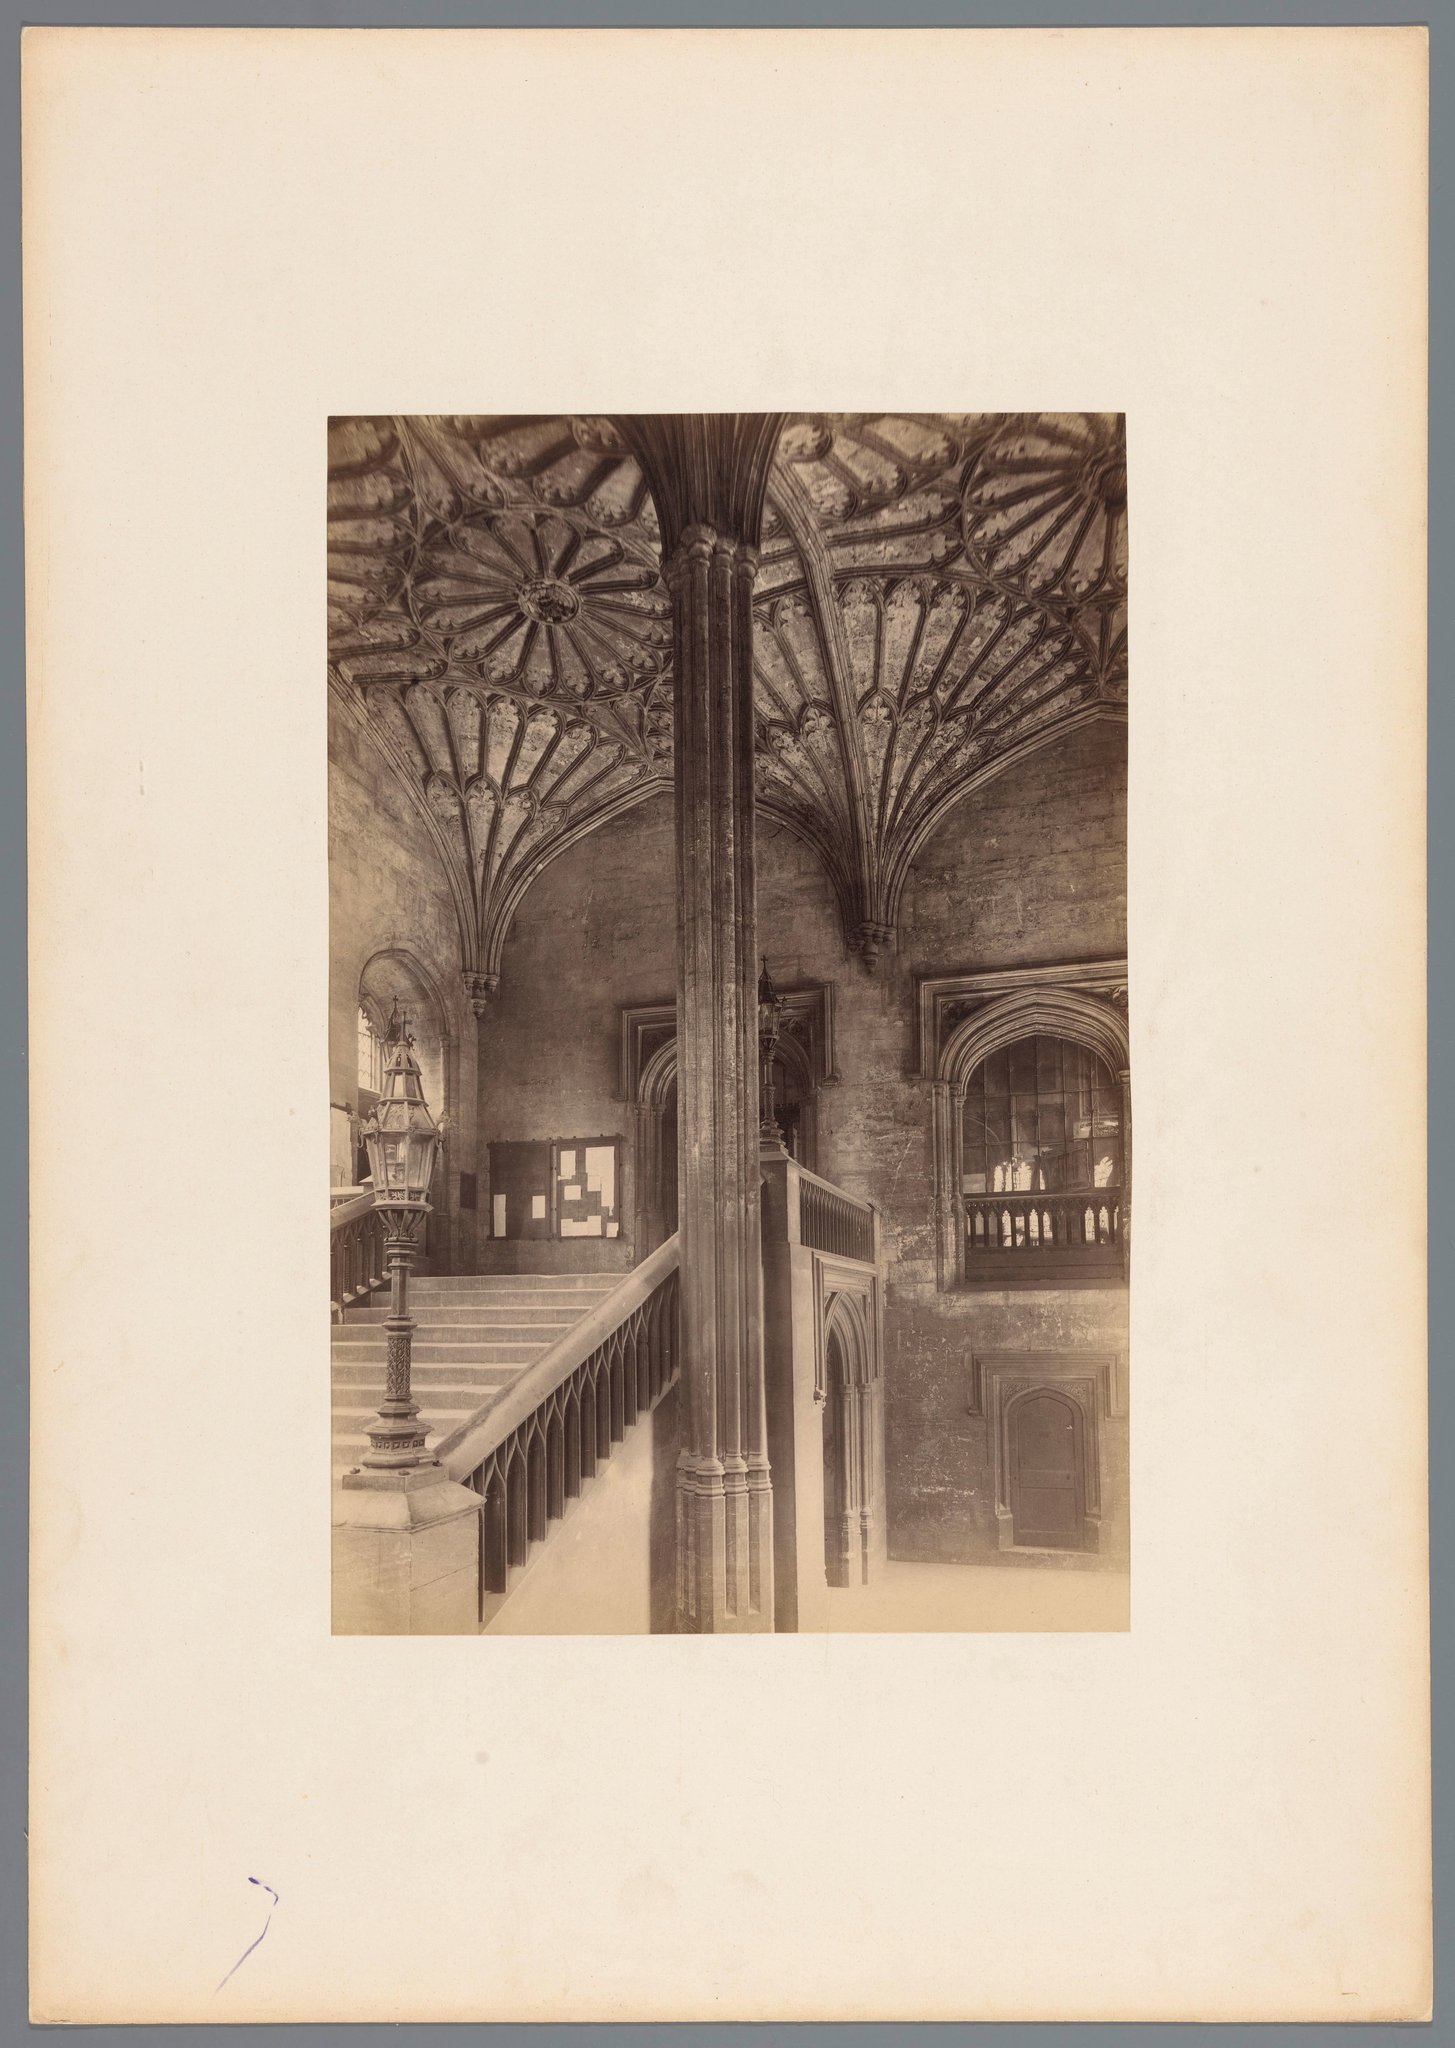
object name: photograph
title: Loggia met een trap en een gewelf gedecoreerd met ribben in rozetvorm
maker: Anonymous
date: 1875-1900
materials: cardboard, photographic support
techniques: albumen print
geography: europe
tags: staircase, loggia, verandah, porch, europe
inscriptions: collector's mark: ‘INSTITUUT VOOR KUNST-NIJVERHEIDSONDERWIJS GABRIËL METSUSTRAAT No. 16 AMSTERDAM’, collector's mark: ‘KUNSTNIJVERHEIDSCHOOL QUELLINUS AMSTERDAM FRANS HALSSTRAAT 14.’